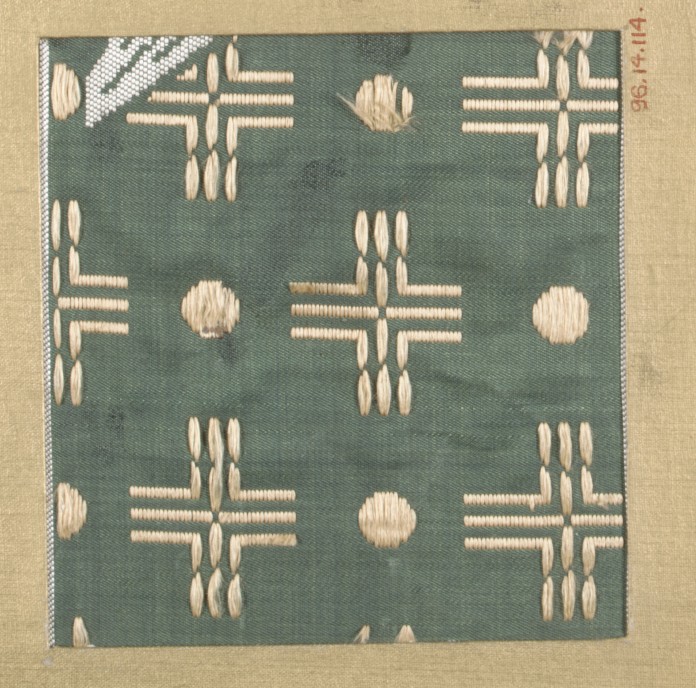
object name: piece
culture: japanese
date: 1701-1900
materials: silk